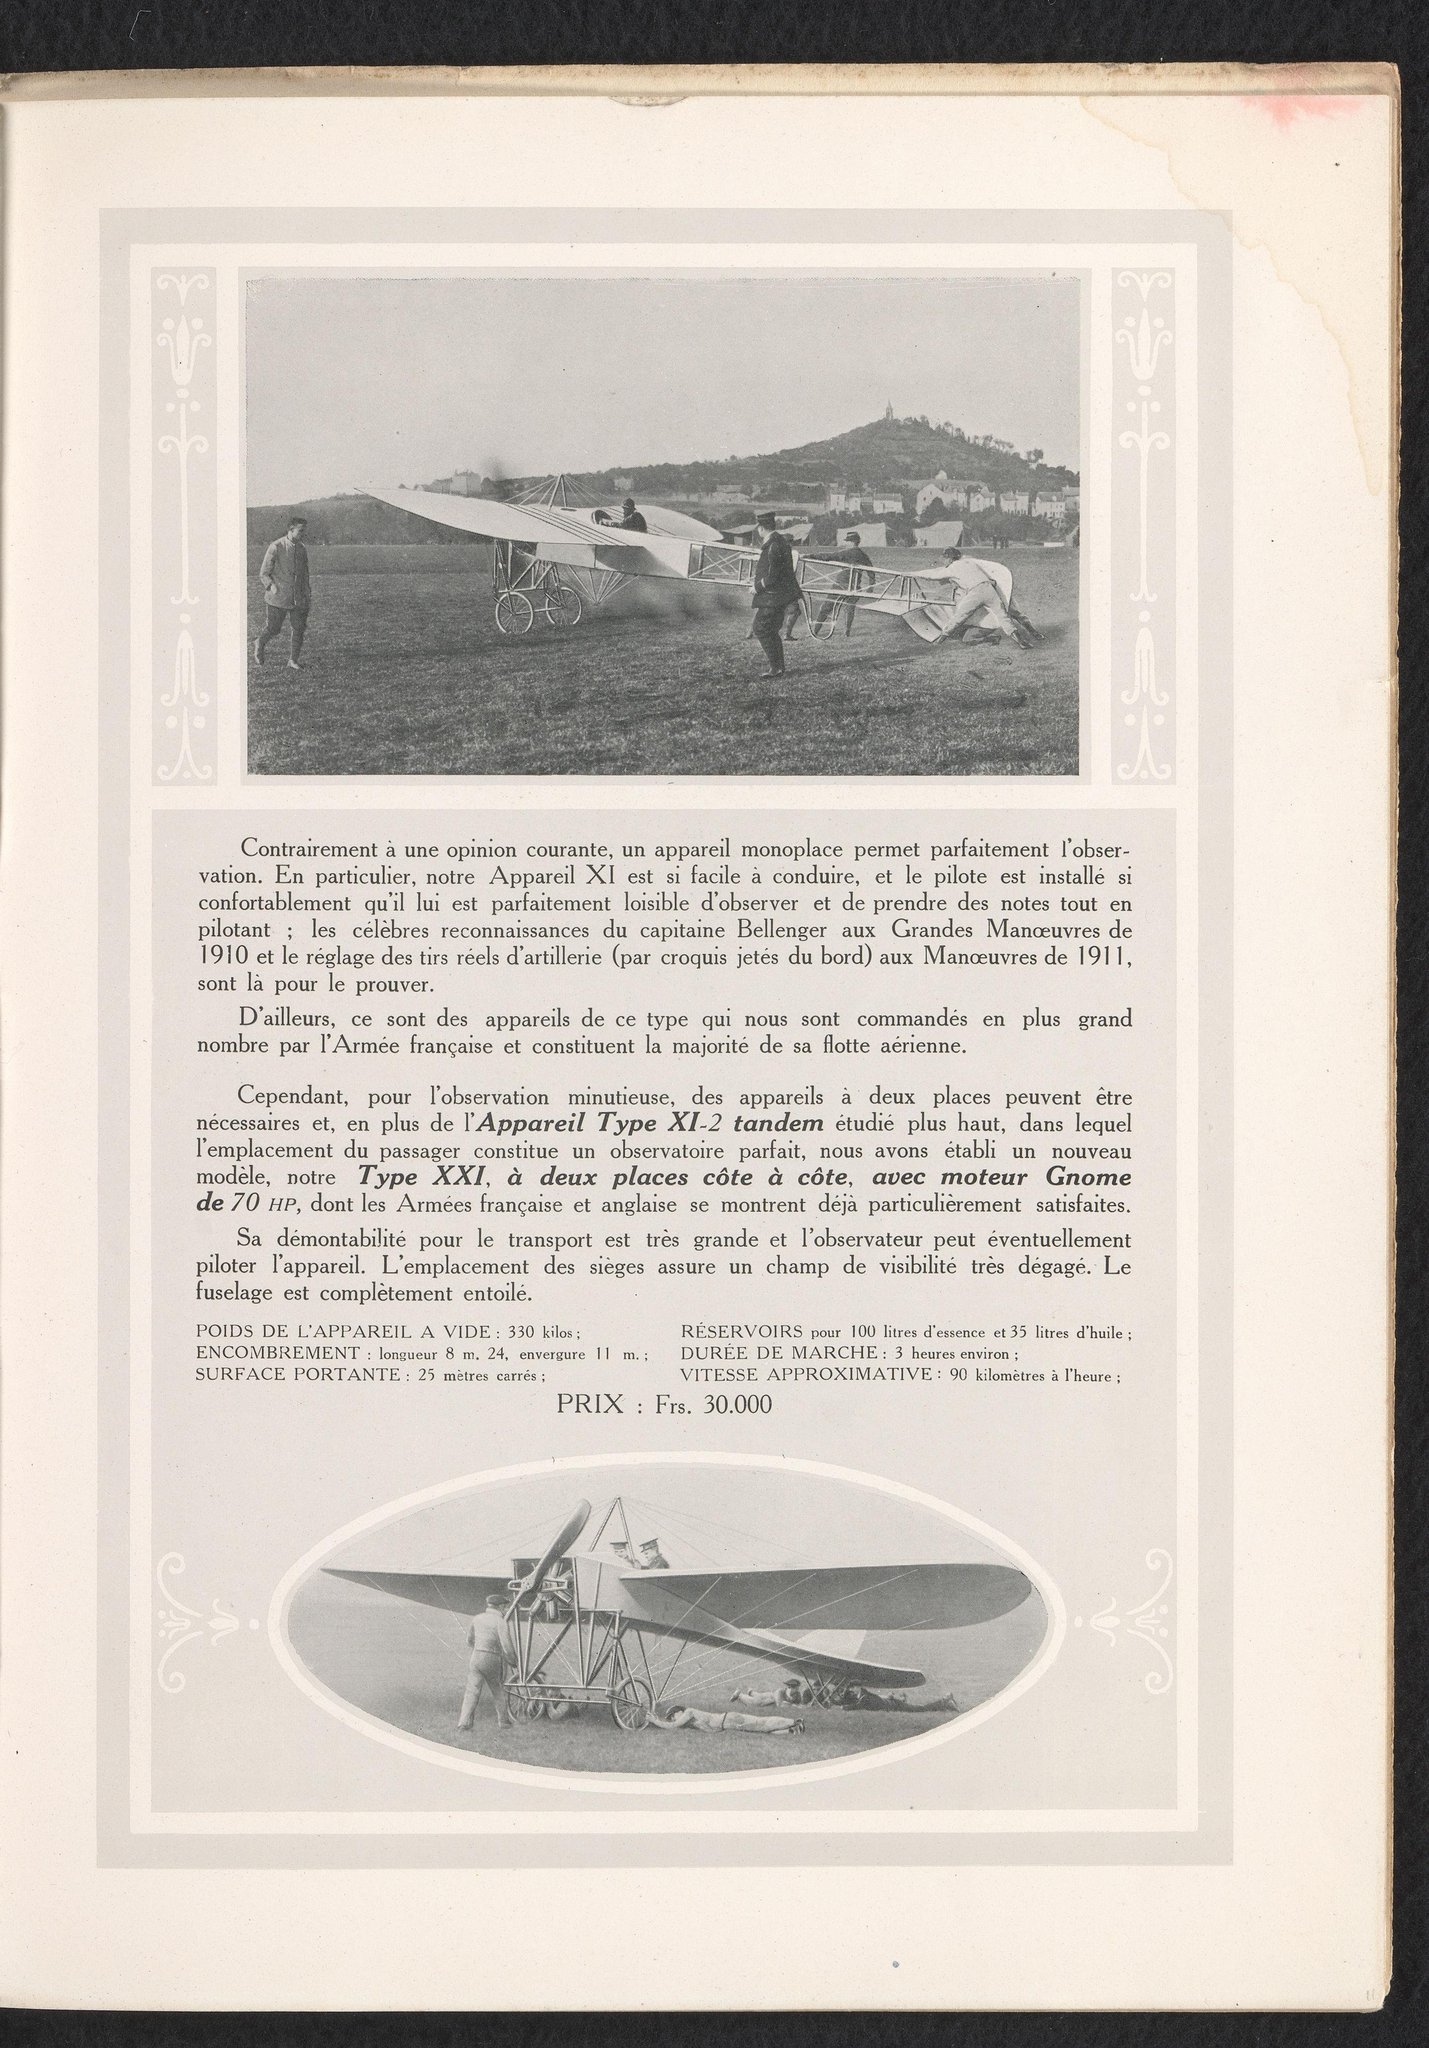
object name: page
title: Vliegtuigen met bemanning in open veld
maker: Anonymous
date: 1907-1912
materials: paper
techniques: letterpress printing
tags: aircraft, aeroplane, pilot, plain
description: Prenten op dertiende ongenummerde pagina.